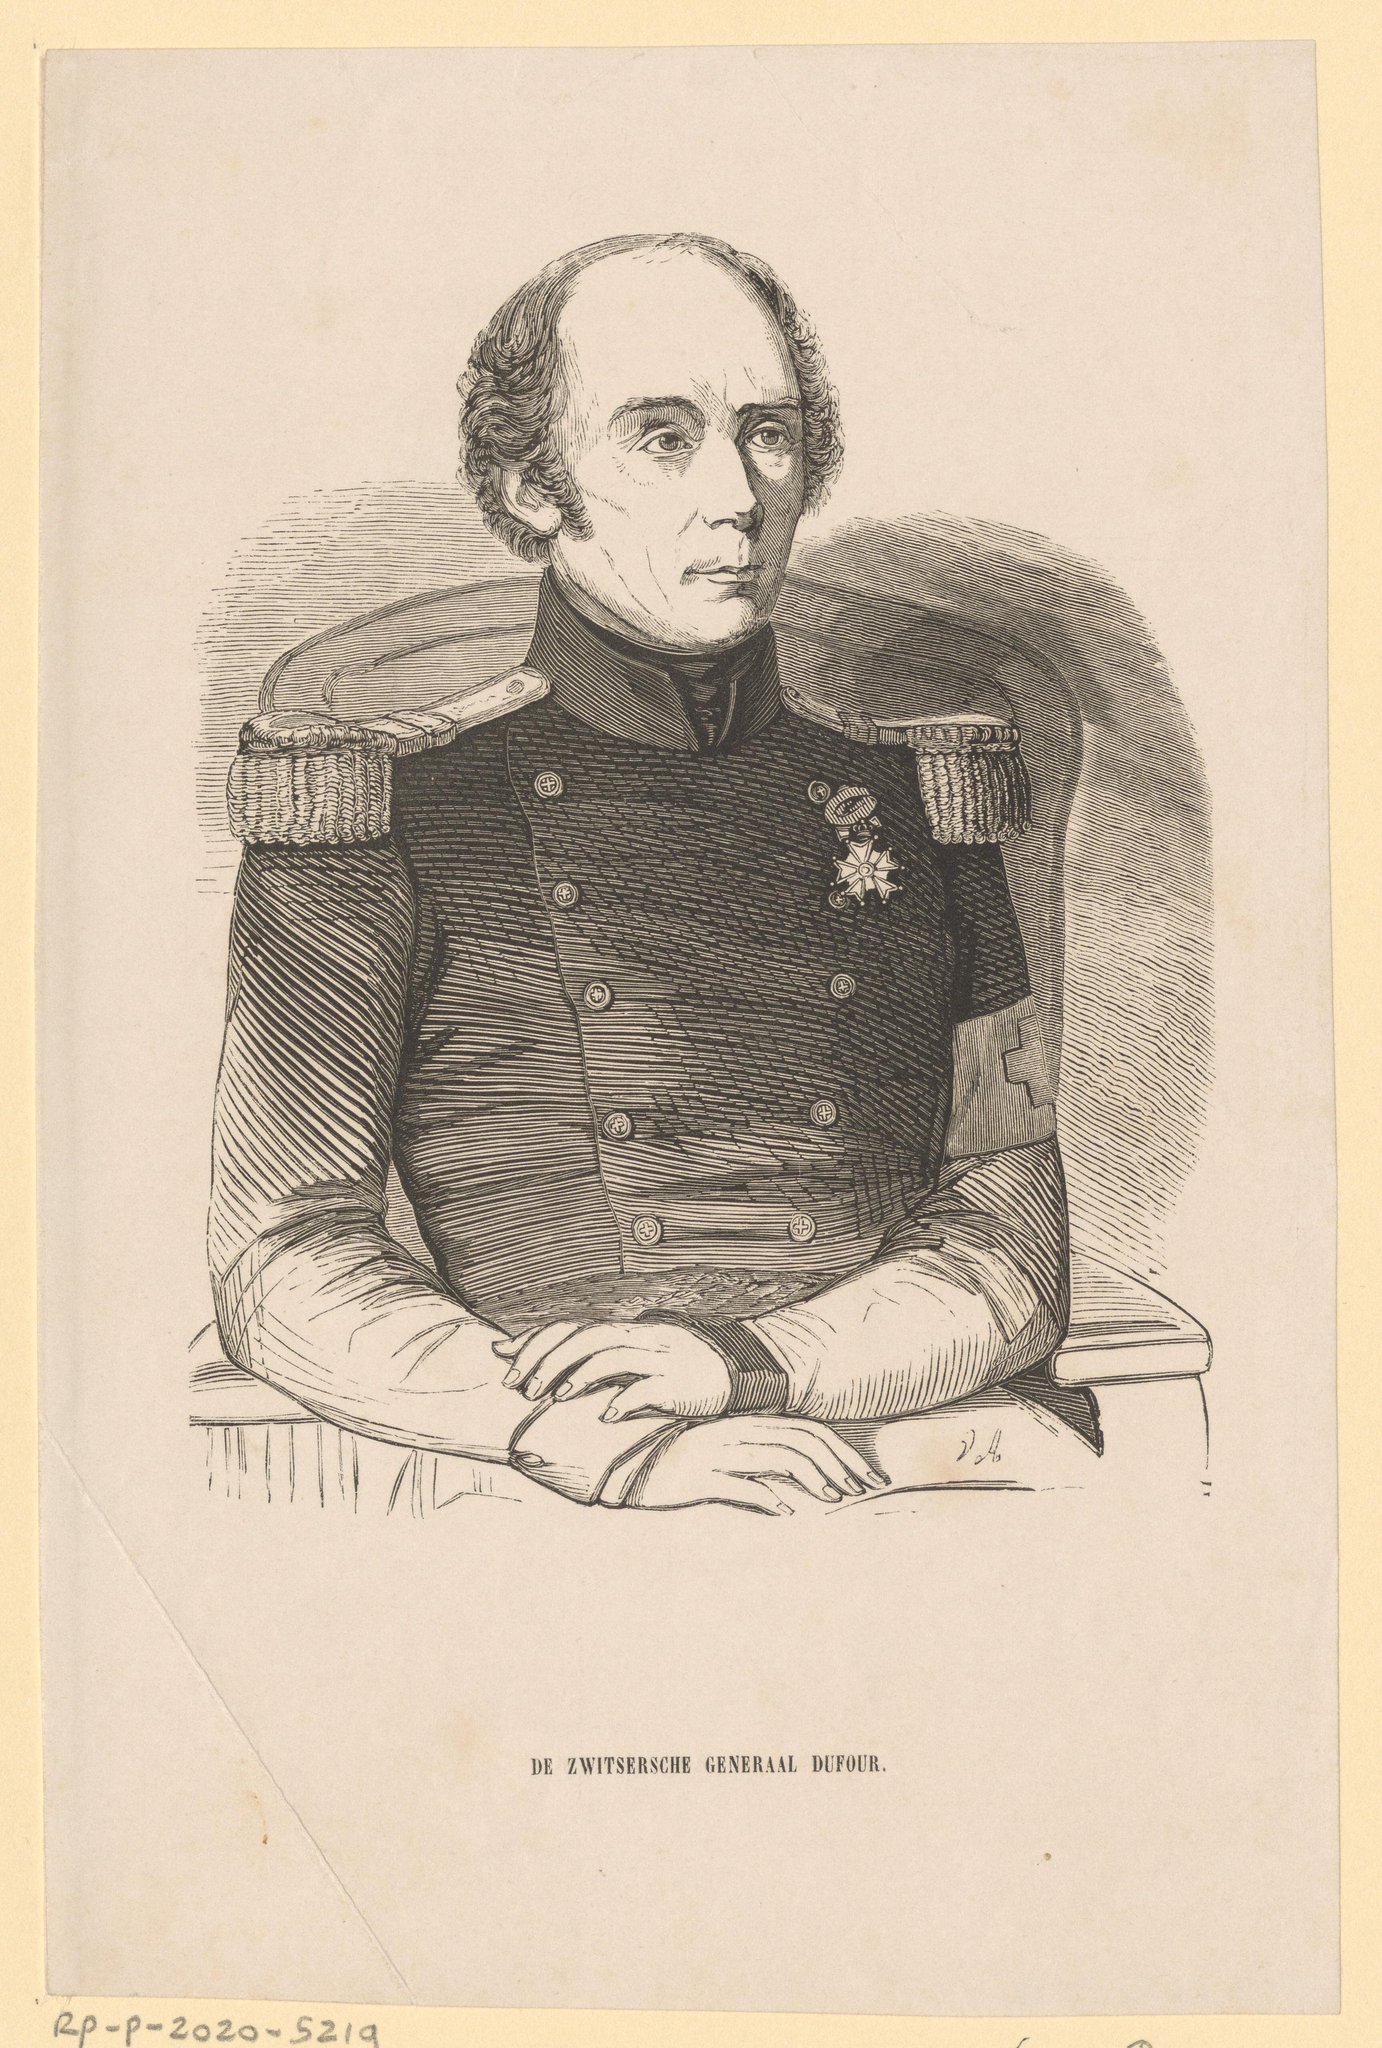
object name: print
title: Portret van Guillaume Henri Dufour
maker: rombertus julianus van arum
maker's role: print maker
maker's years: 1812-1883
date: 1847-1883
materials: paper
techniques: engraving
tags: commander-in-chief, general, marshal, historical persons